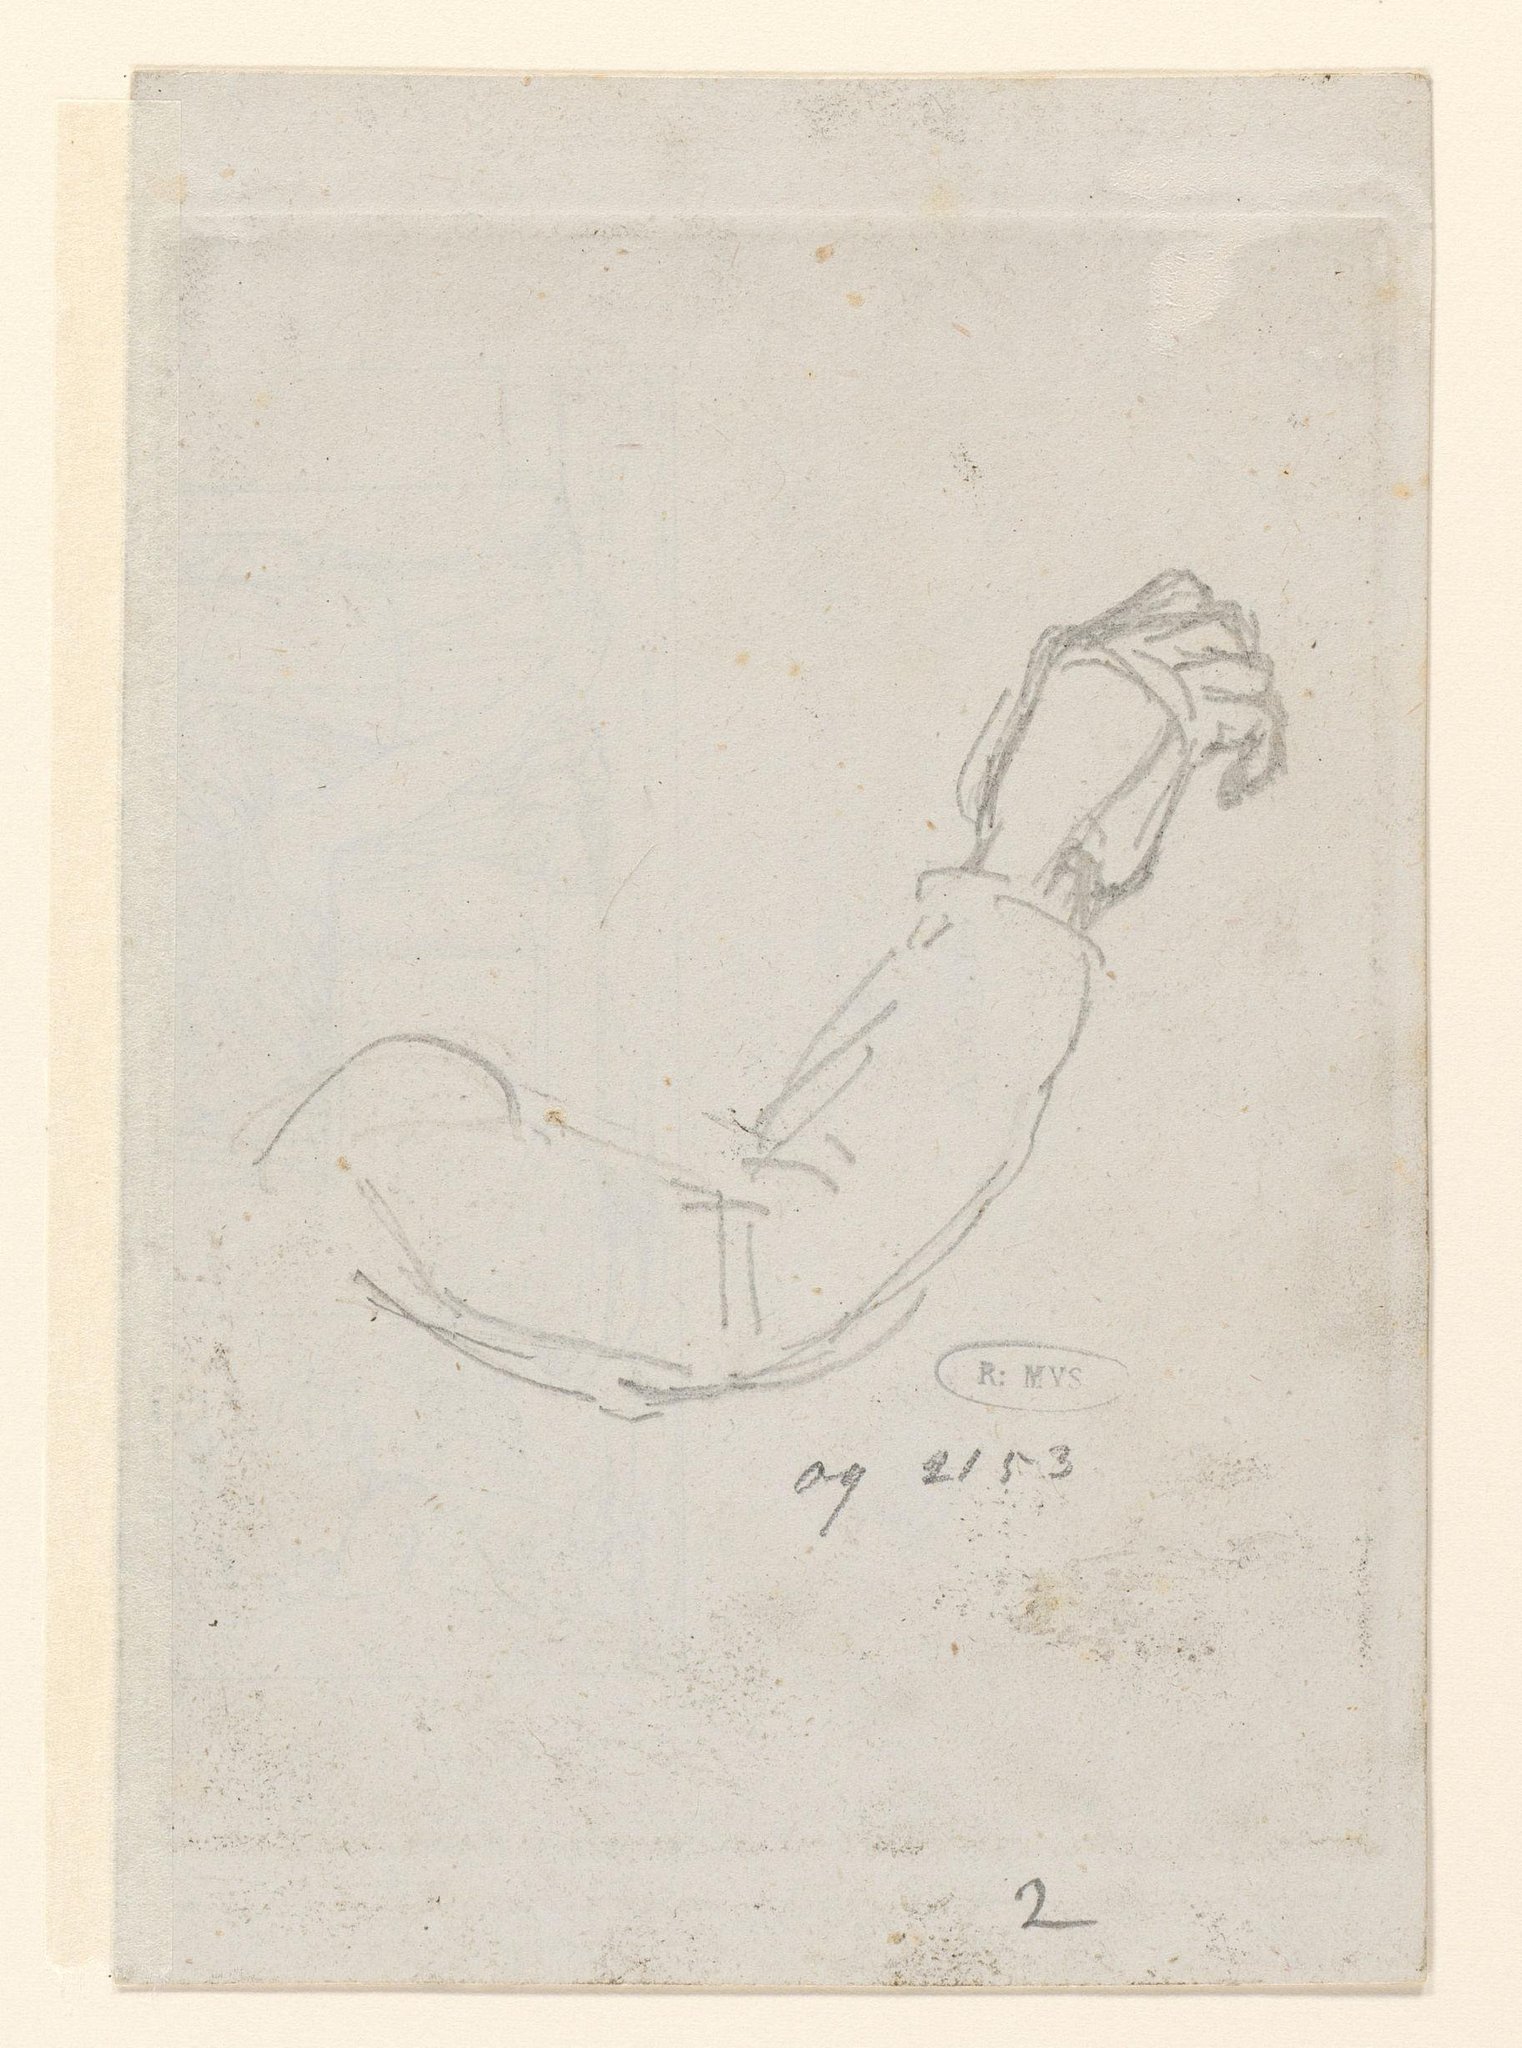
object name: print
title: Arm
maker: vicomte arthur-jean le bailly dinghuem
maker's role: print maker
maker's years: 1839-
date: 1875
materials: paper, pencil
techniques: intaglio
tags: arm raised upward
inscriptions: collector's mark: Lugt 2228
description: Schets van de arm van de man met tamboerijn op recto zijde.